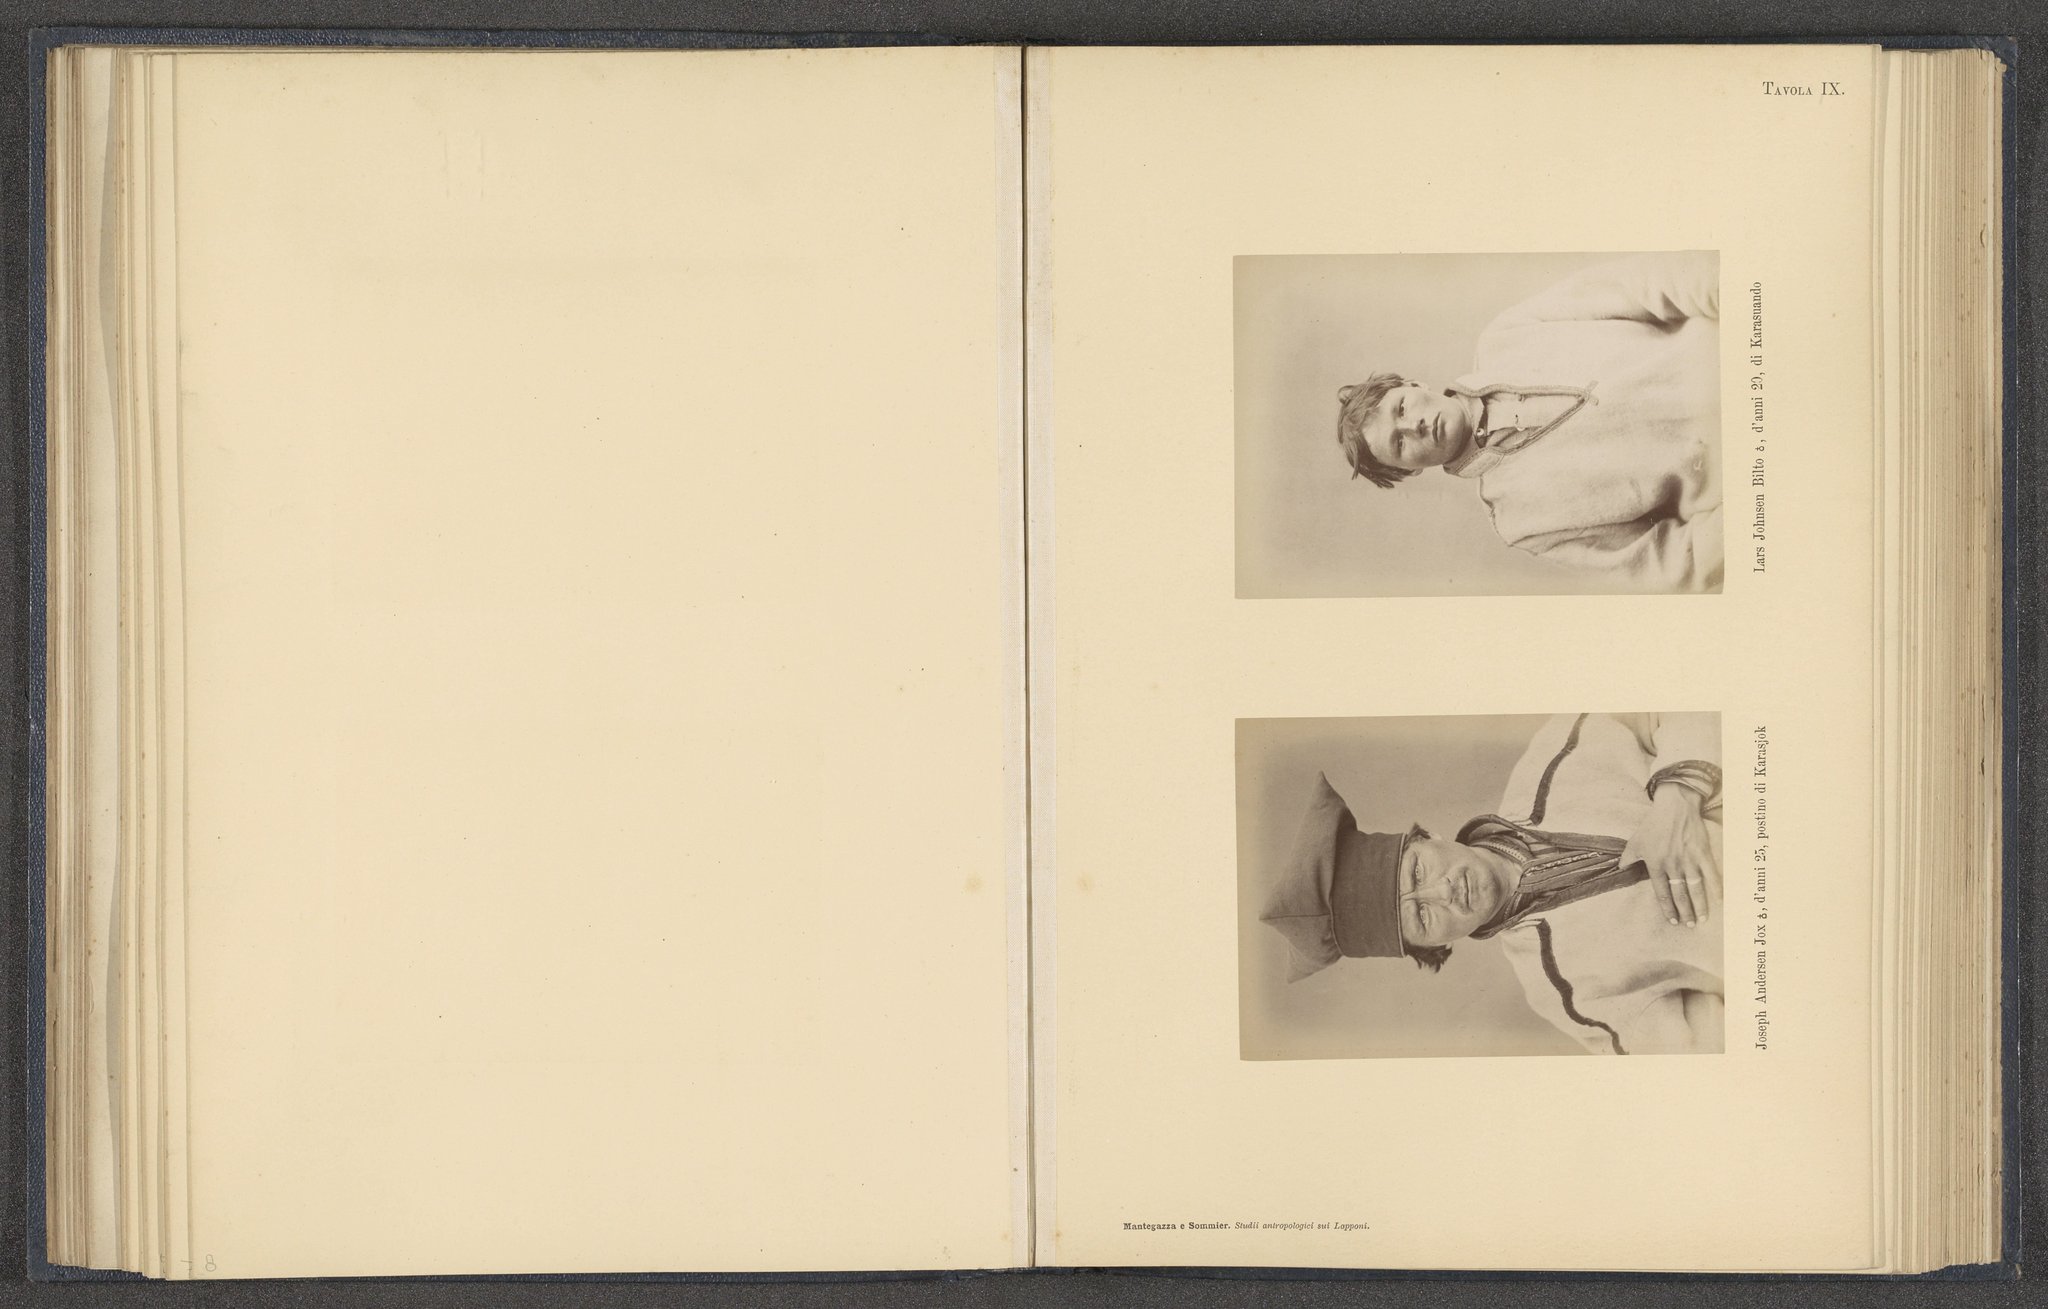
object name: page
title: Twee portretten van Joseph Andersen Jox en Lars Johnsen Bilto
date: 1870-1880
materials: paper, photographic support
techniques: albumen print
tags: head-gear, adult man (+ front view)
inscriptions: number: ‘Tavola IX.’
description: Links een vooraanzicht van Joseph Andersen Jox, rechts een vooraanzicht van Lars Johnsen Bilto.